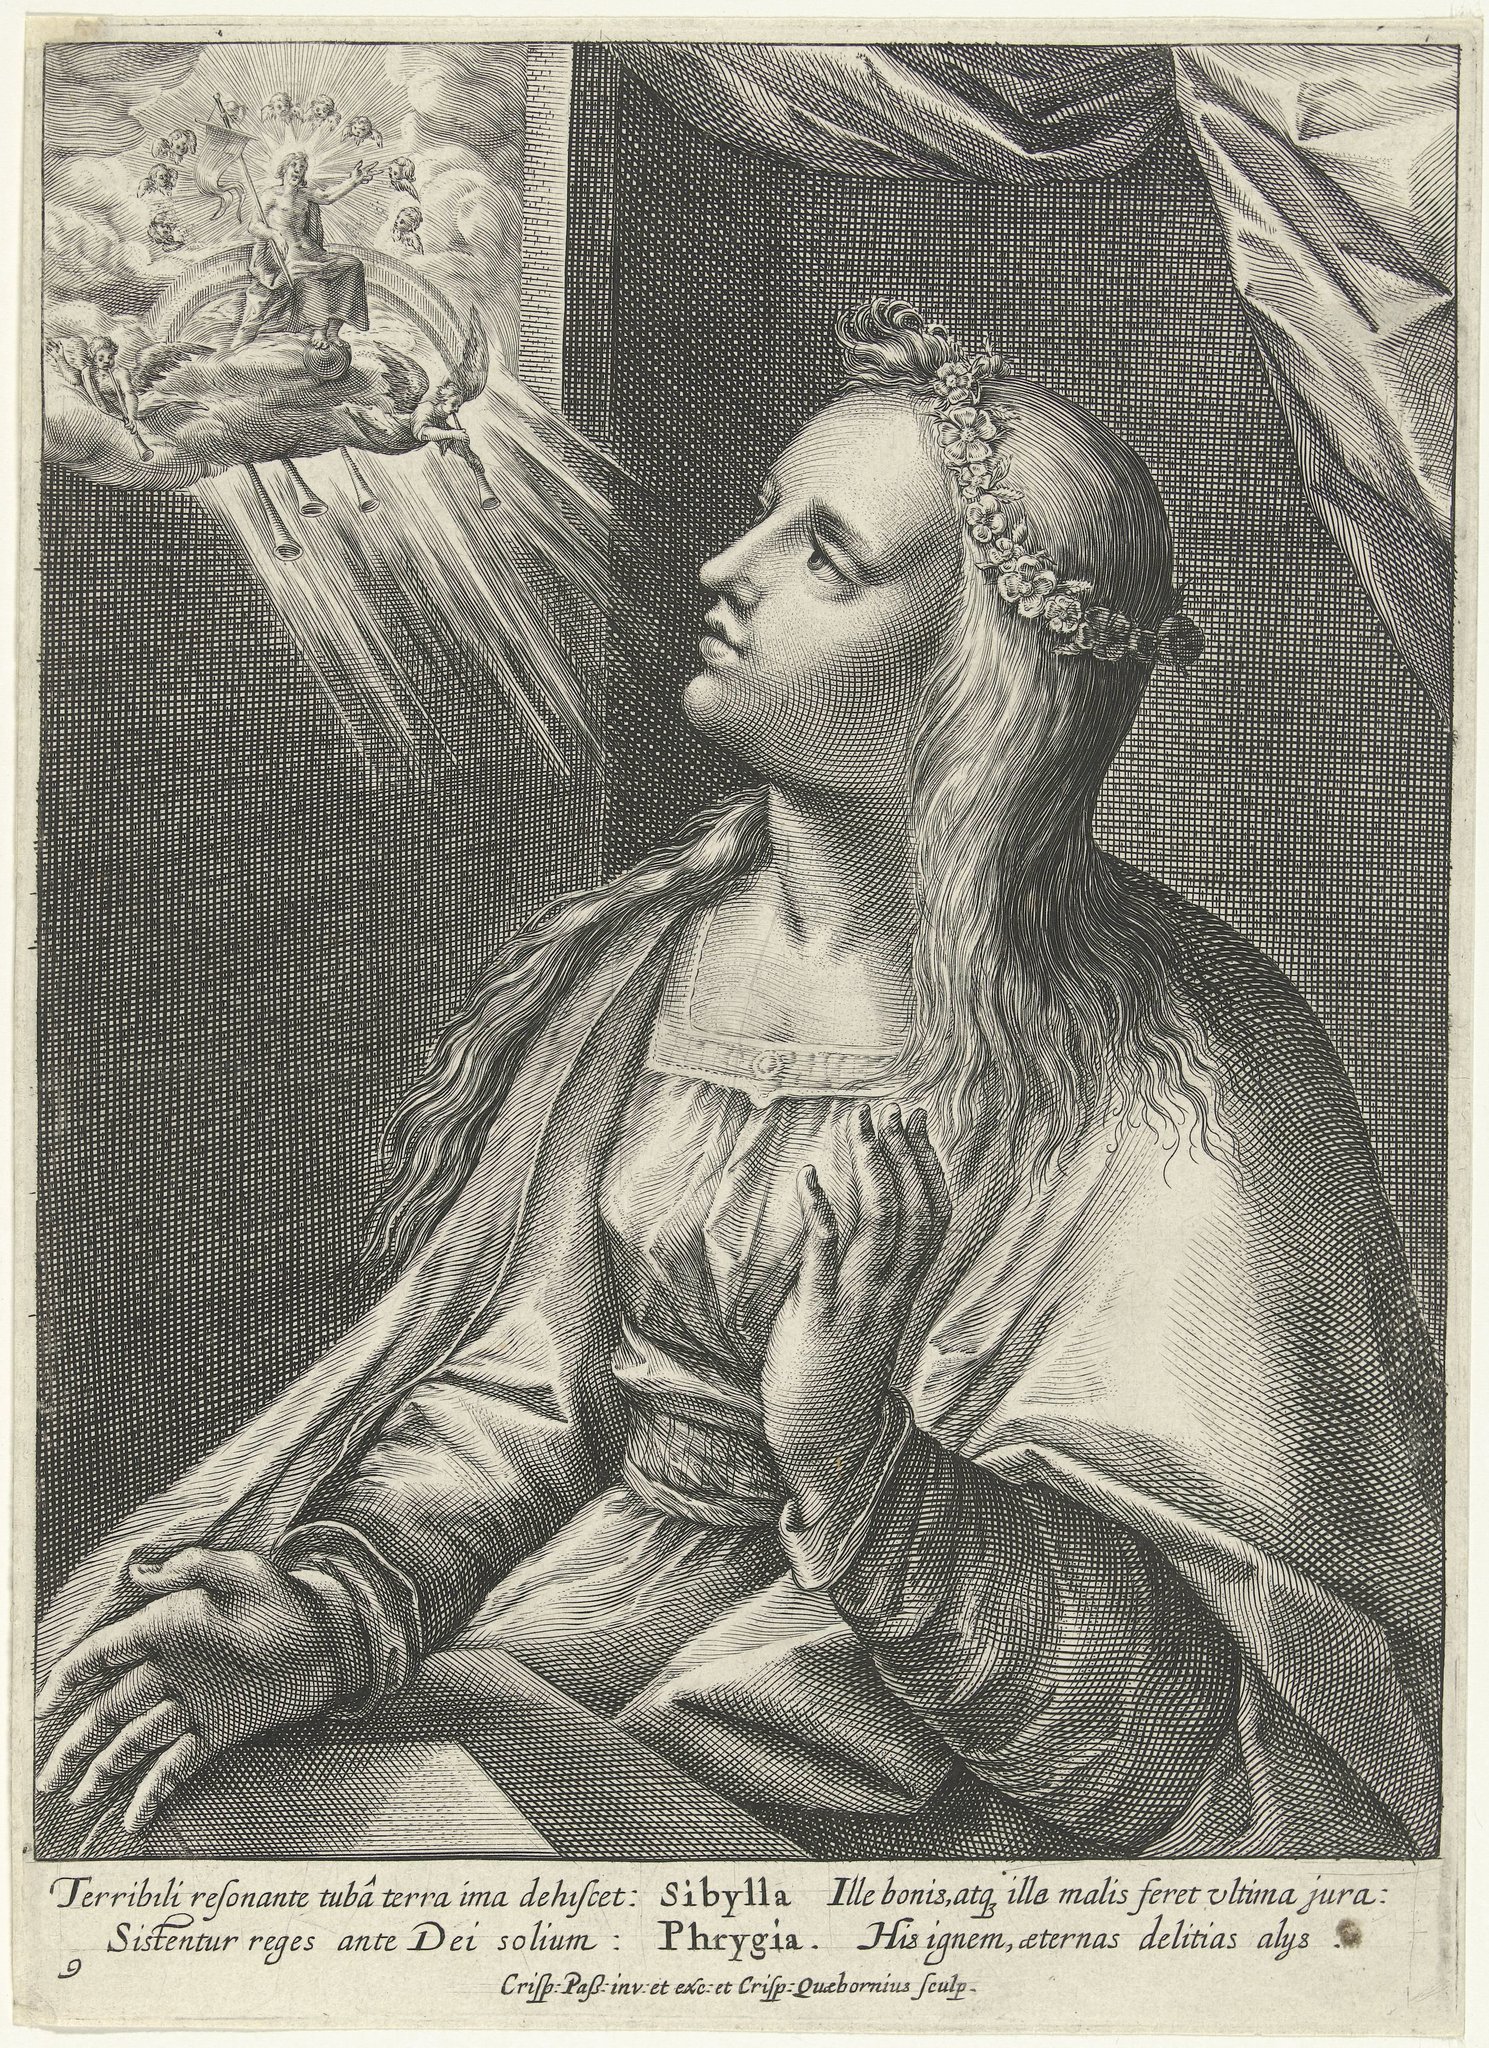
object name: print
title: Sibillen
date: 1615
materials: paper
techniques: engraving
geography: utrecht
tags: 'salvator mundi', making a blessing gesture; an orb in his hand or at his feet, vision in trance or ecstasy, sibyls (with name)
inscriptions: collector's mark: Lugt 240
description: De Frygische Sibille kijkt omhoog waar Christus als overwinnaar op een wolk verschijnt. Hij houdt een banier met een kruis erop in de hand en laat zijn voet rusten op een wereldbol. Hij wordt vergezeld door engelen met bazuinen. Onder de voorstelling een onderschrift in het Latijn.